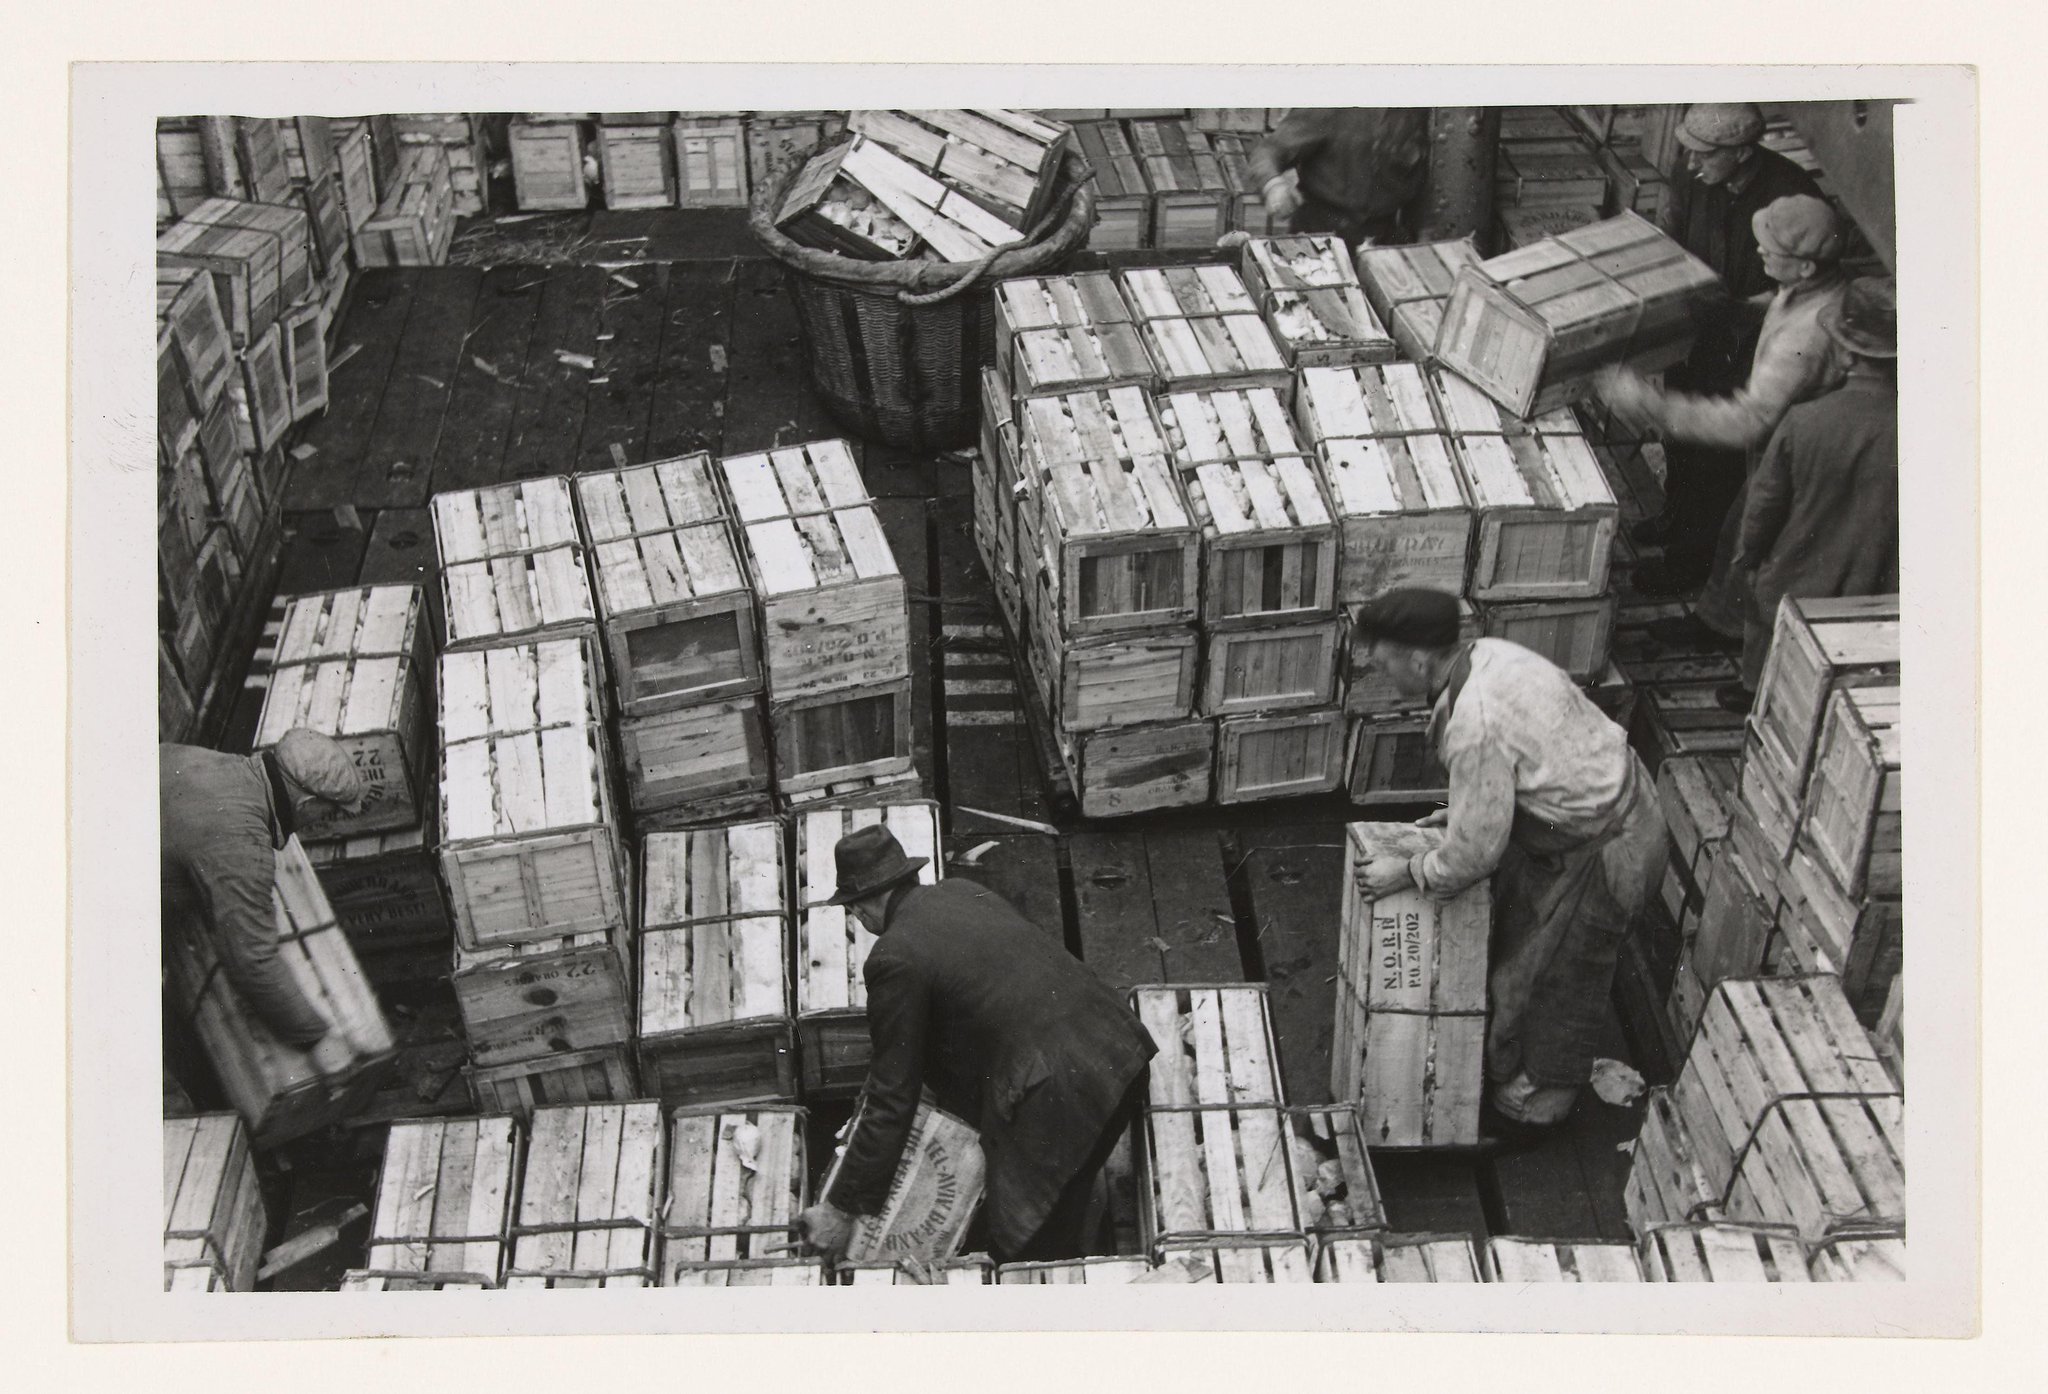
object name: documentary photograph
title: Het lossen van sinaasappelkisten in de haven van Rotterdam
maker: van t hof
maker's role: fotograaf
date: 1946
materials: photographic support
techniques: photography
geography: rotterdam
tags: publisher, rotterdam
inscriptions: number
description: Zie ook Collectie ANEFO, Nationaal Archief, fotonummers: 901_3518, 901_3519, 901_3526 tot en met 901_3529. Zie voor meer info en foto's Ons vrije Nederland: geïllustreerd weekblad, jaargangen 1944 - 1950.